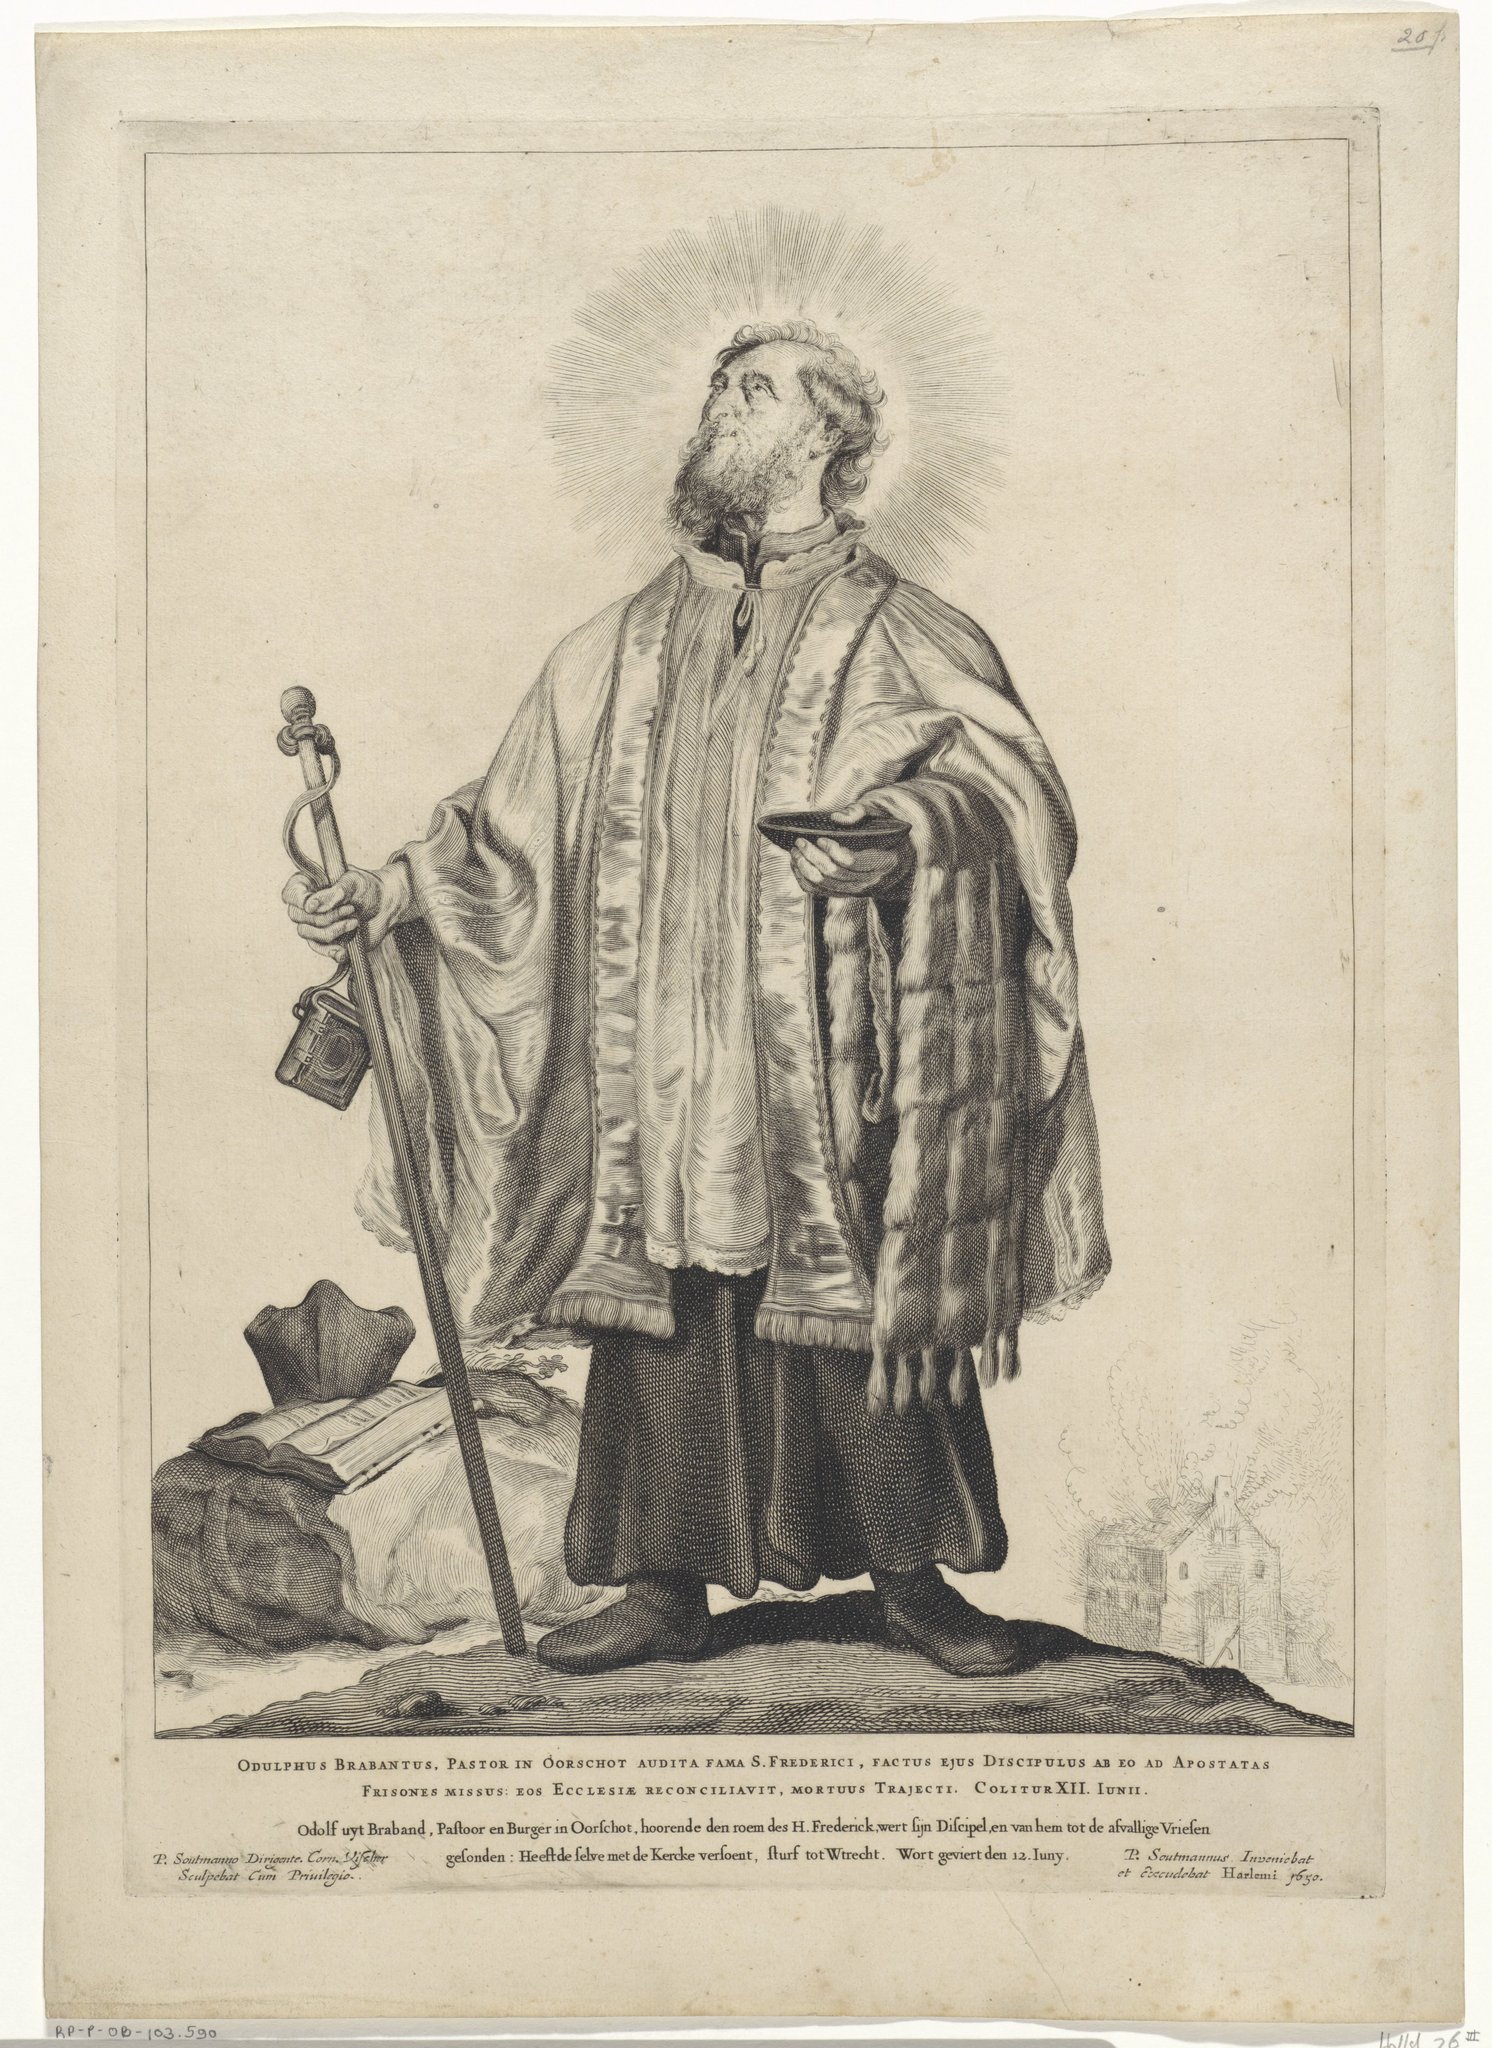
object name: print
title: H. Odulphus van Brabant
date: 1650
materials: paper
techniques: engraving, etching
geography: haarlem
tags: oirschot, heilige, odulphus van brabant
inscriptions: collector's mark: Lugt 240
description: Deze prent maakt deel uit van de serie: Iesv Christo, Fideli Militantis Ecclesiae Imperatori, Liberali Eivsdem, Trivmphantis, Remvneratori, hos In Foederato Belgio Militiae Svae Legatos, Sanctissimos Sacri Belli Dvces, Patriae Apostolos, Et Decora Lvmina, Cvm Dvabvs Heroinis, Militans In Iisdem Provinciis Ecclesia. Haarlem: Pieter Claesz. Soutman, 1650.